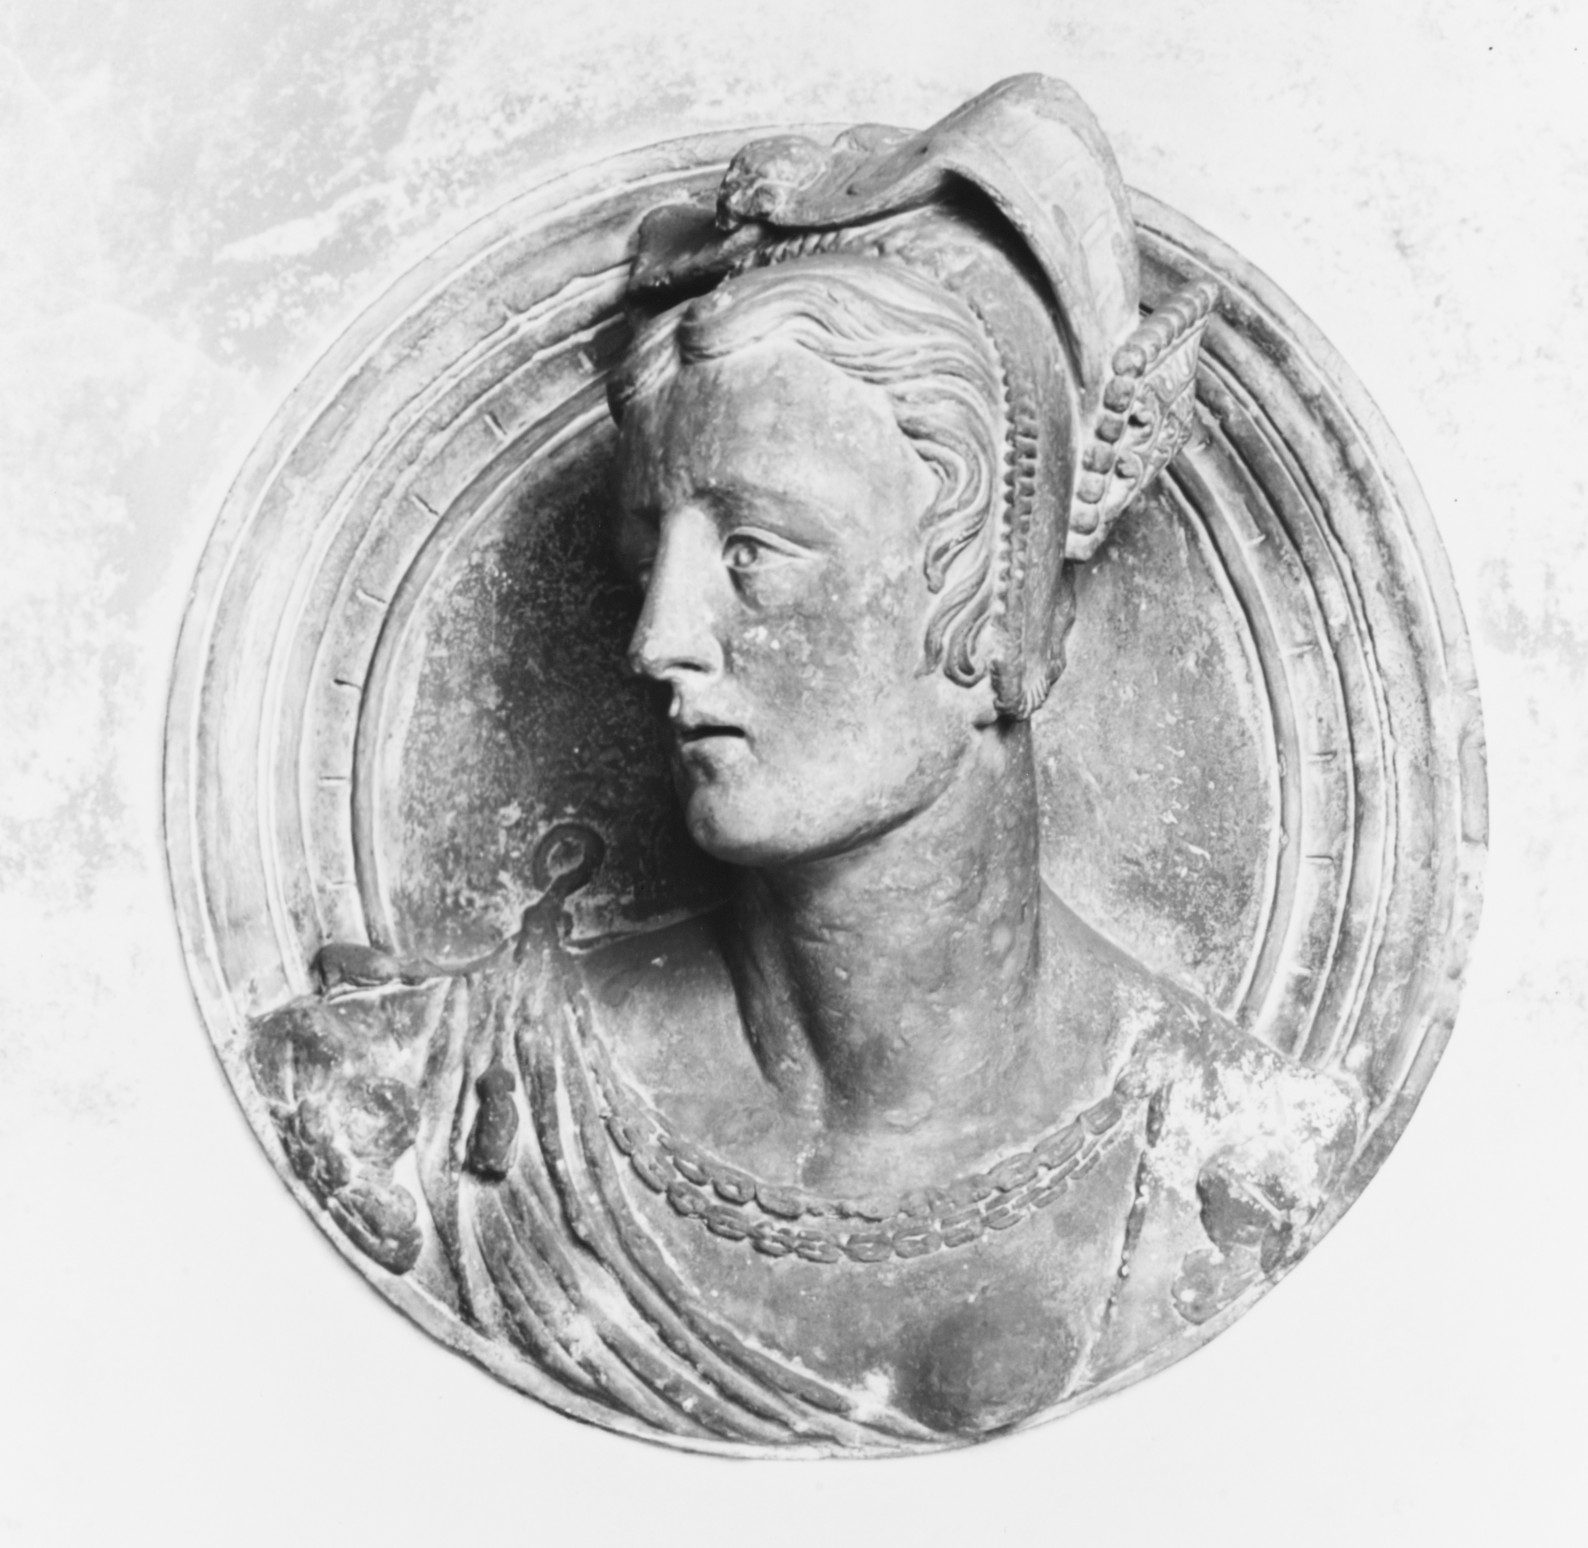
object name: roundel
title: Bust of a lady in contemporary dress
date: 1525-1530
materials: limestone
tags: portraits,women